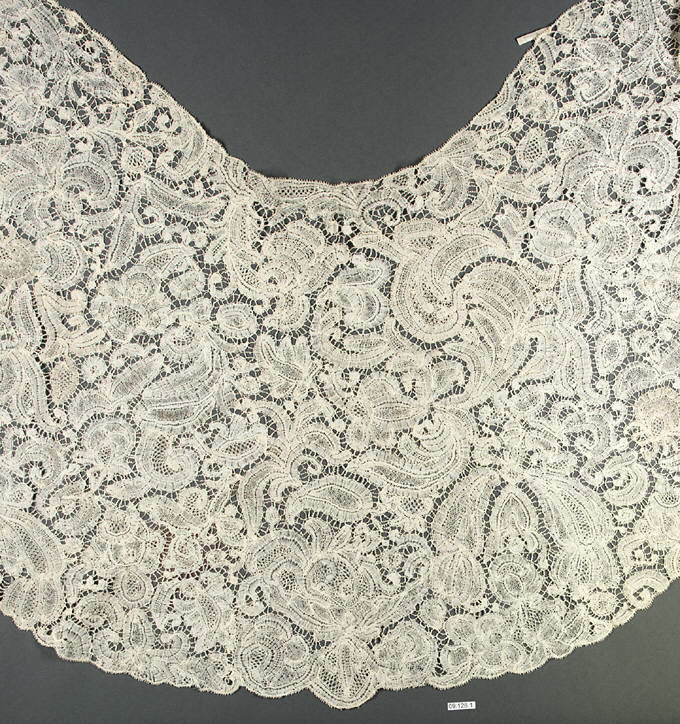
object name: bertha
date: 1667-1700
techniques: lace